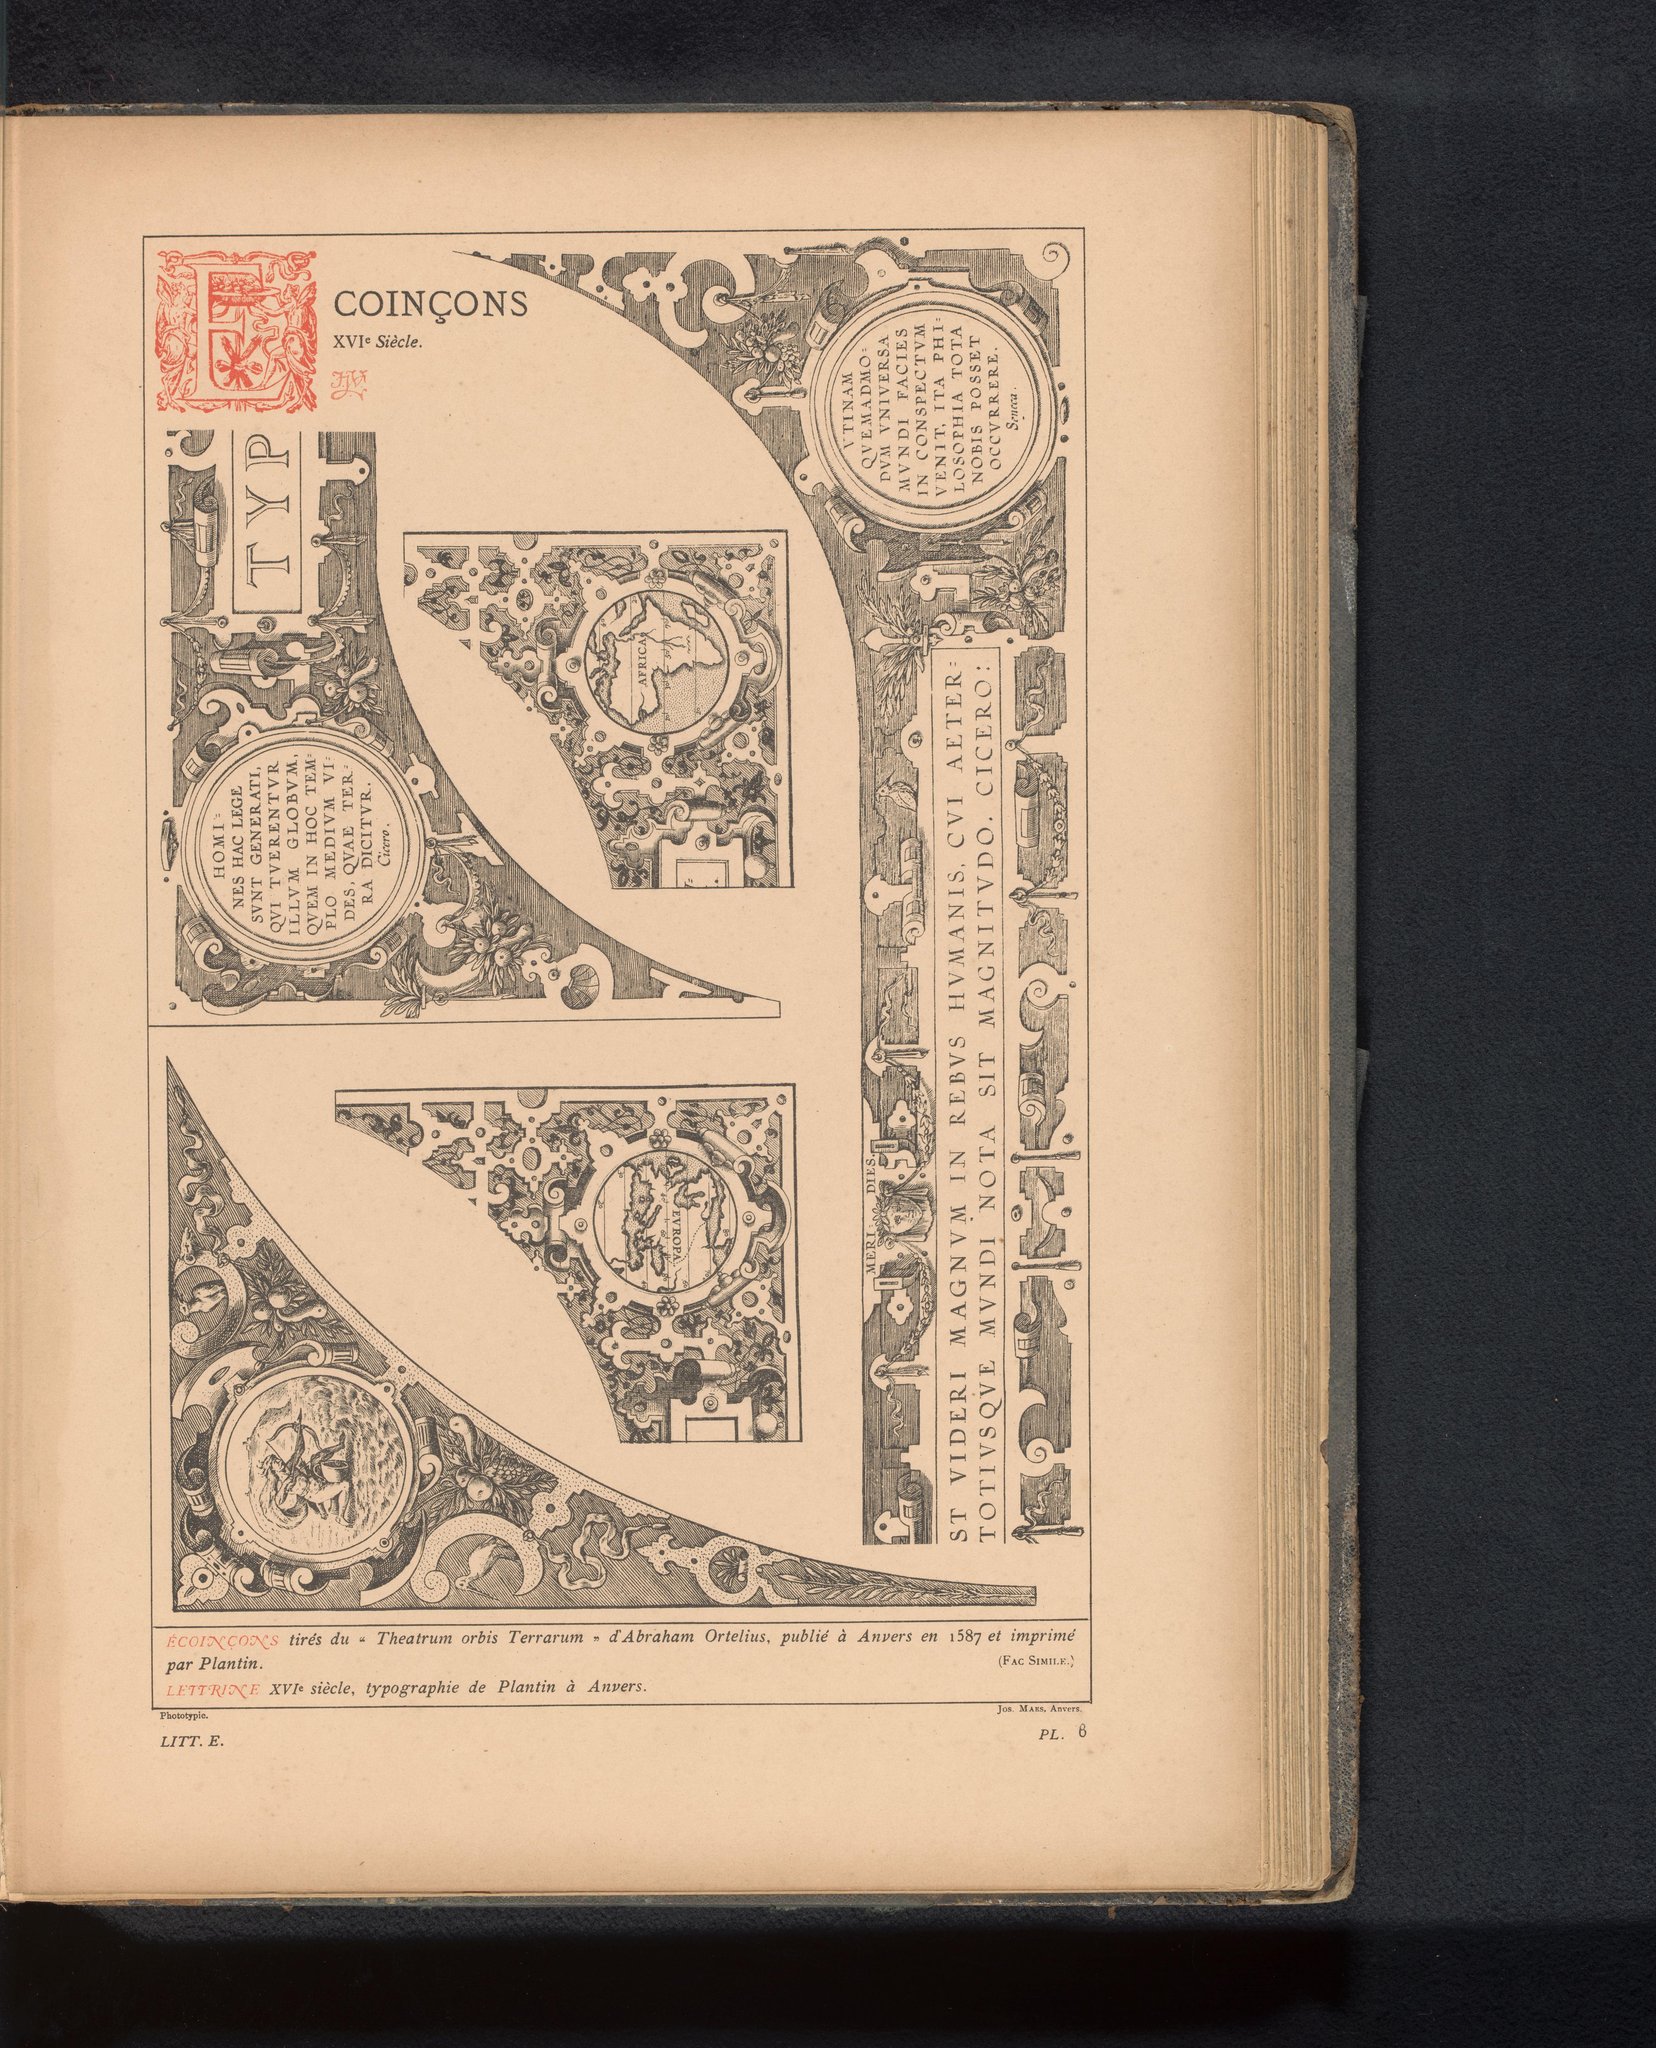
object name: reproduction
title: Reproductie van een prent van vijf gedecoreerde hoeken uit het Theatrum Orbis Terrarum van Abraham Ortelius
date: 1875-1880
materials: paper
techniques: photolithography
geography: antwerp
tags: decoration of printed matter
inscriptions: monogram: ‘JJvY’, inscription: ‘LITT. E. - PL. 8’, inscription: ‘ÉCOINÇONS tirés du (...)’